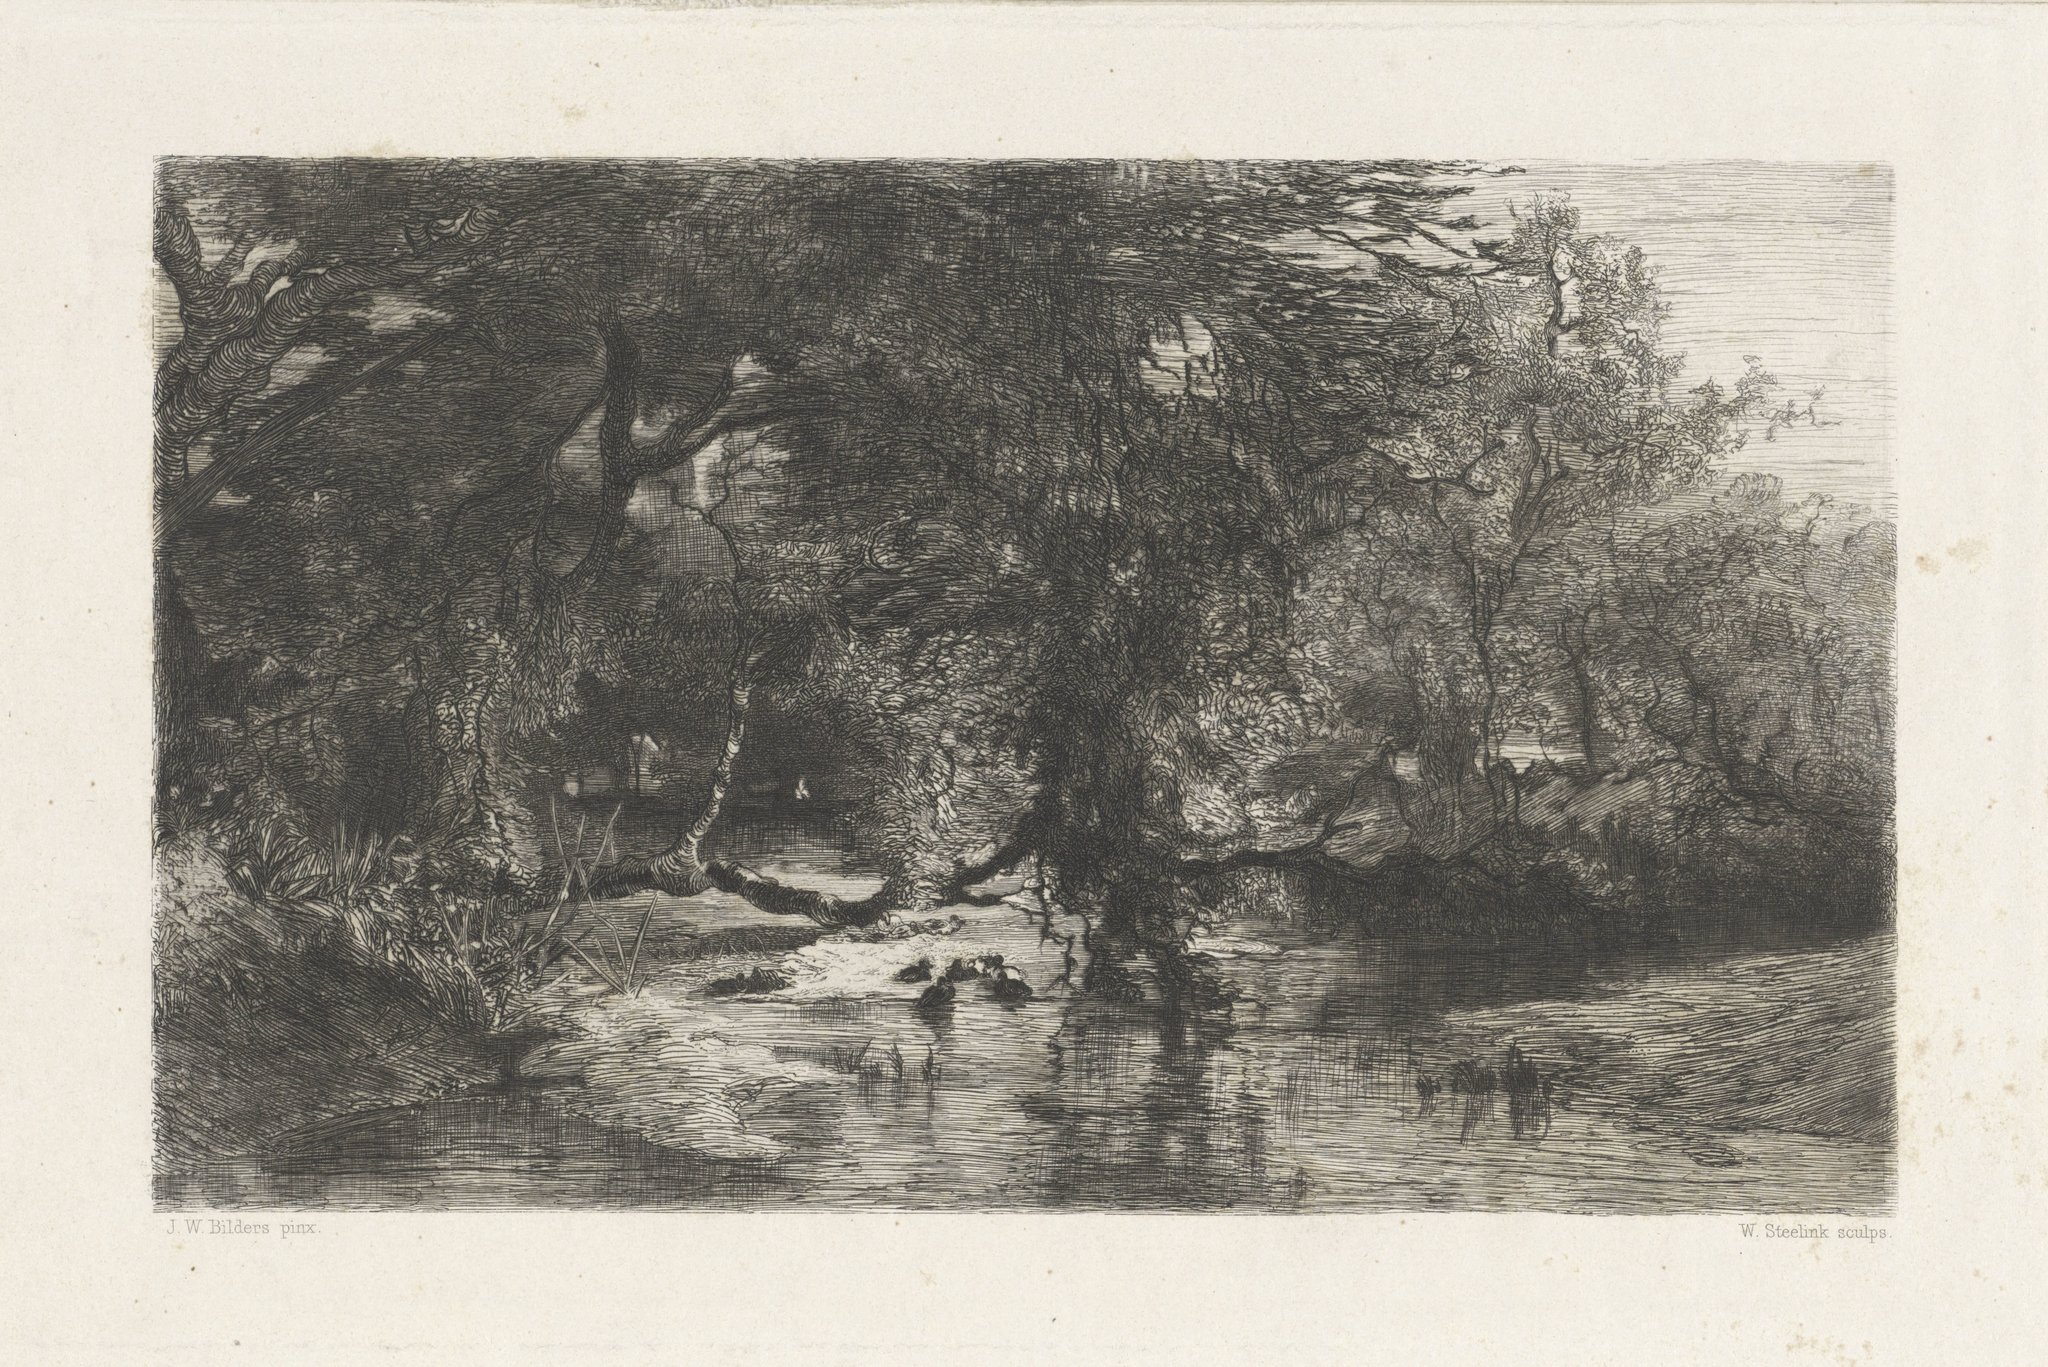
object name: print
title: Bomen langs het water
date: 1836-1902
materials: paper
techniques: etching, intaglio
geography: amsterdam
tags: forest, wood, brook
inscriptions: collector's mark: Lugt 2228